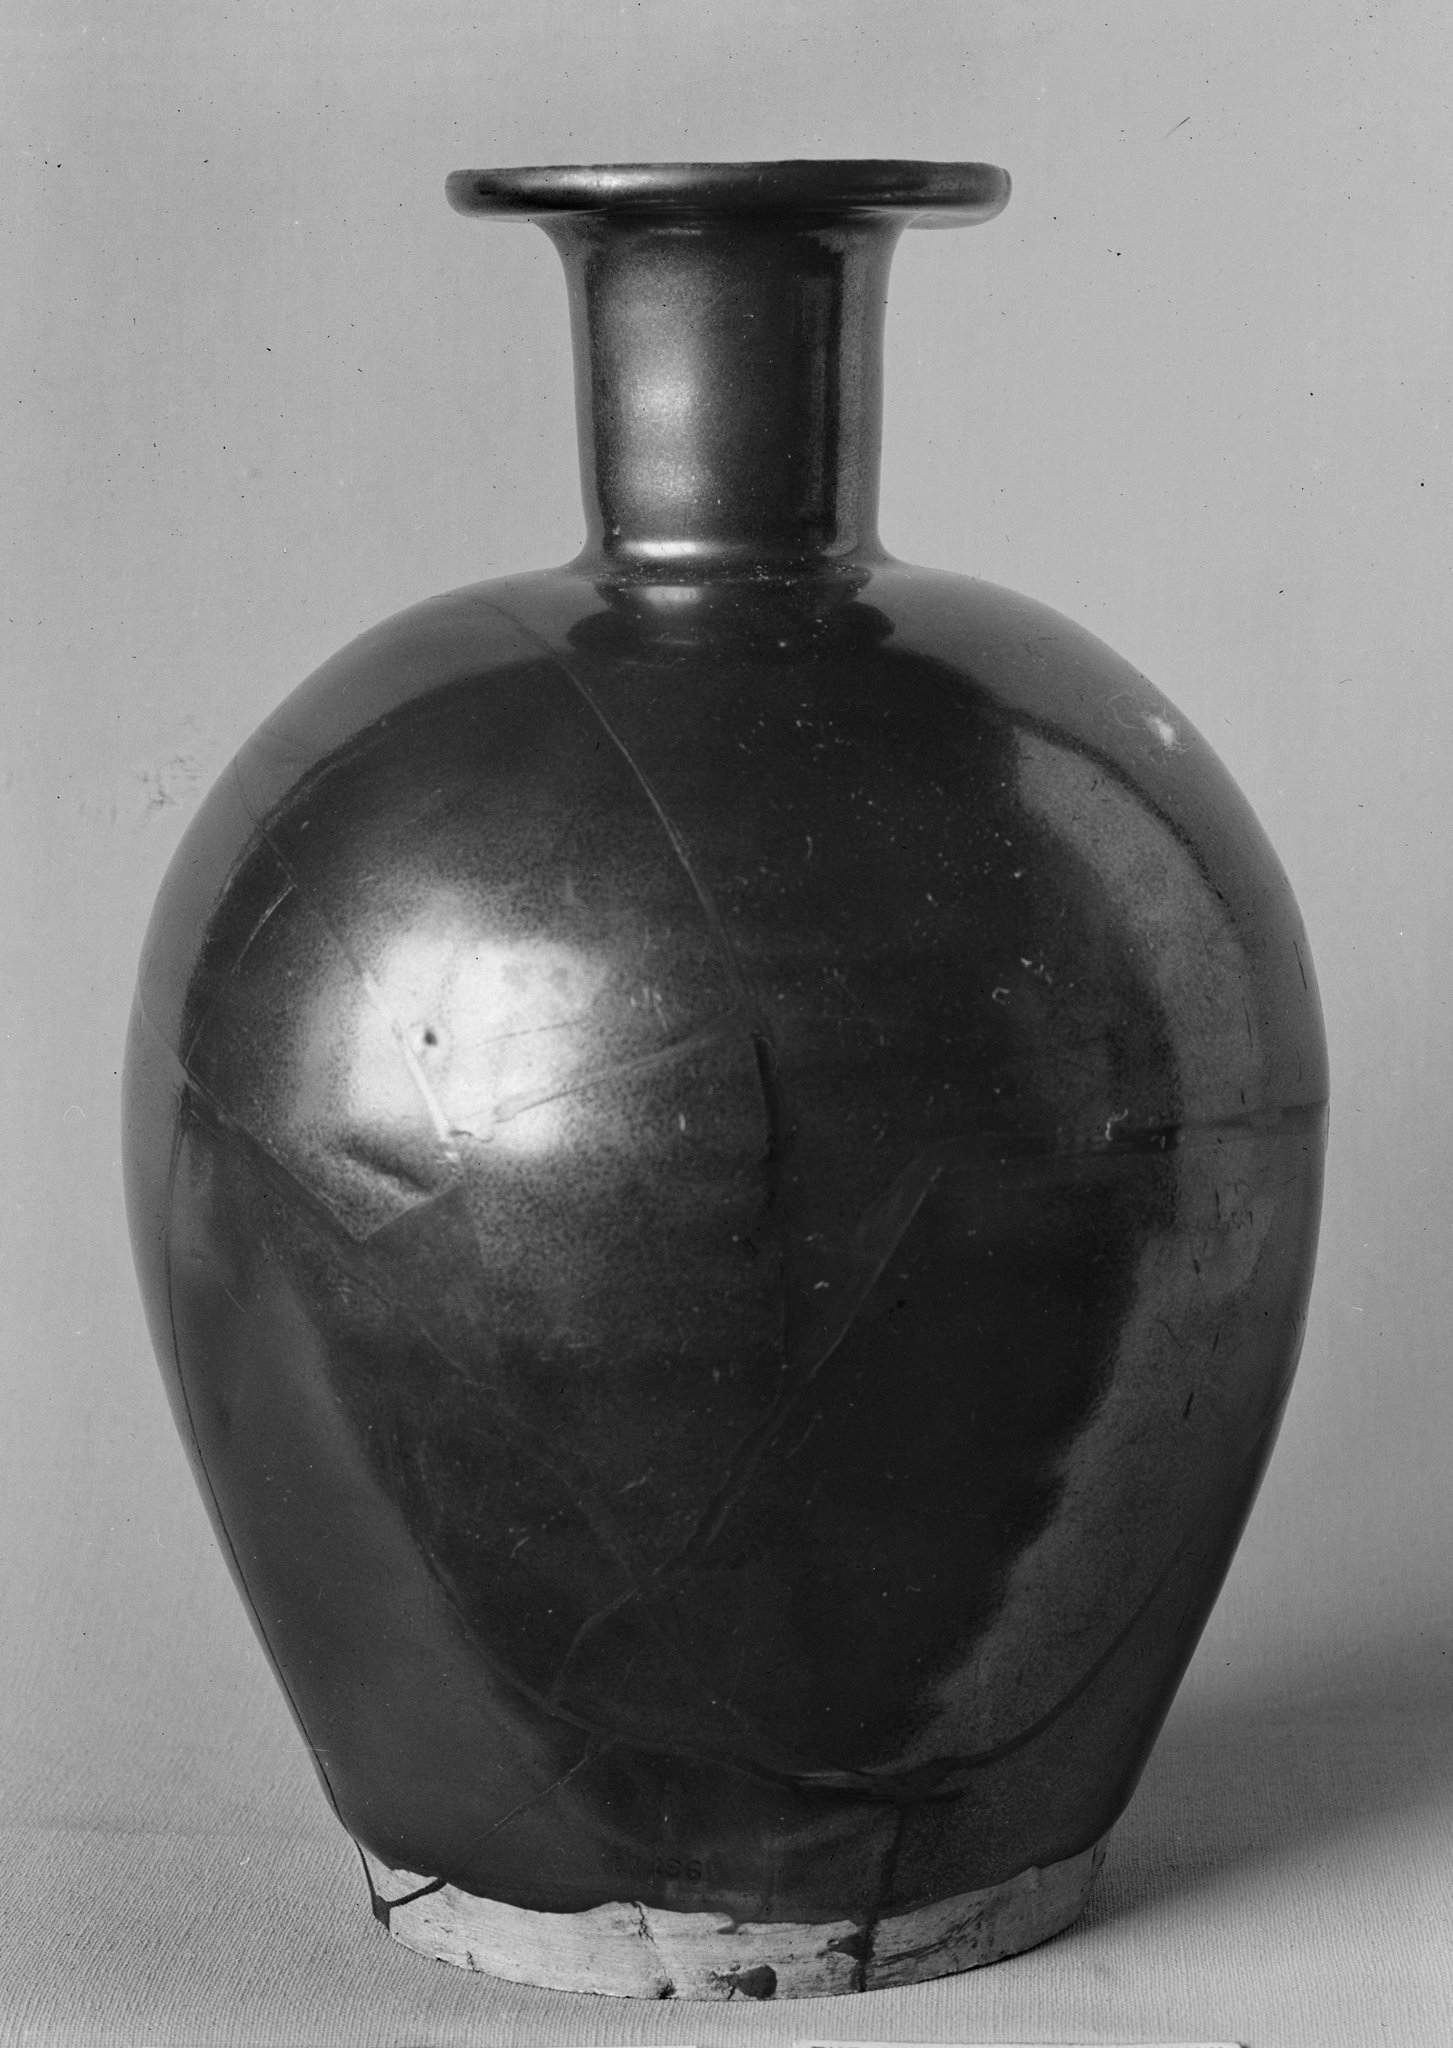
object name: bottle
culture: chinese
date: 960-1279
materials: pottery